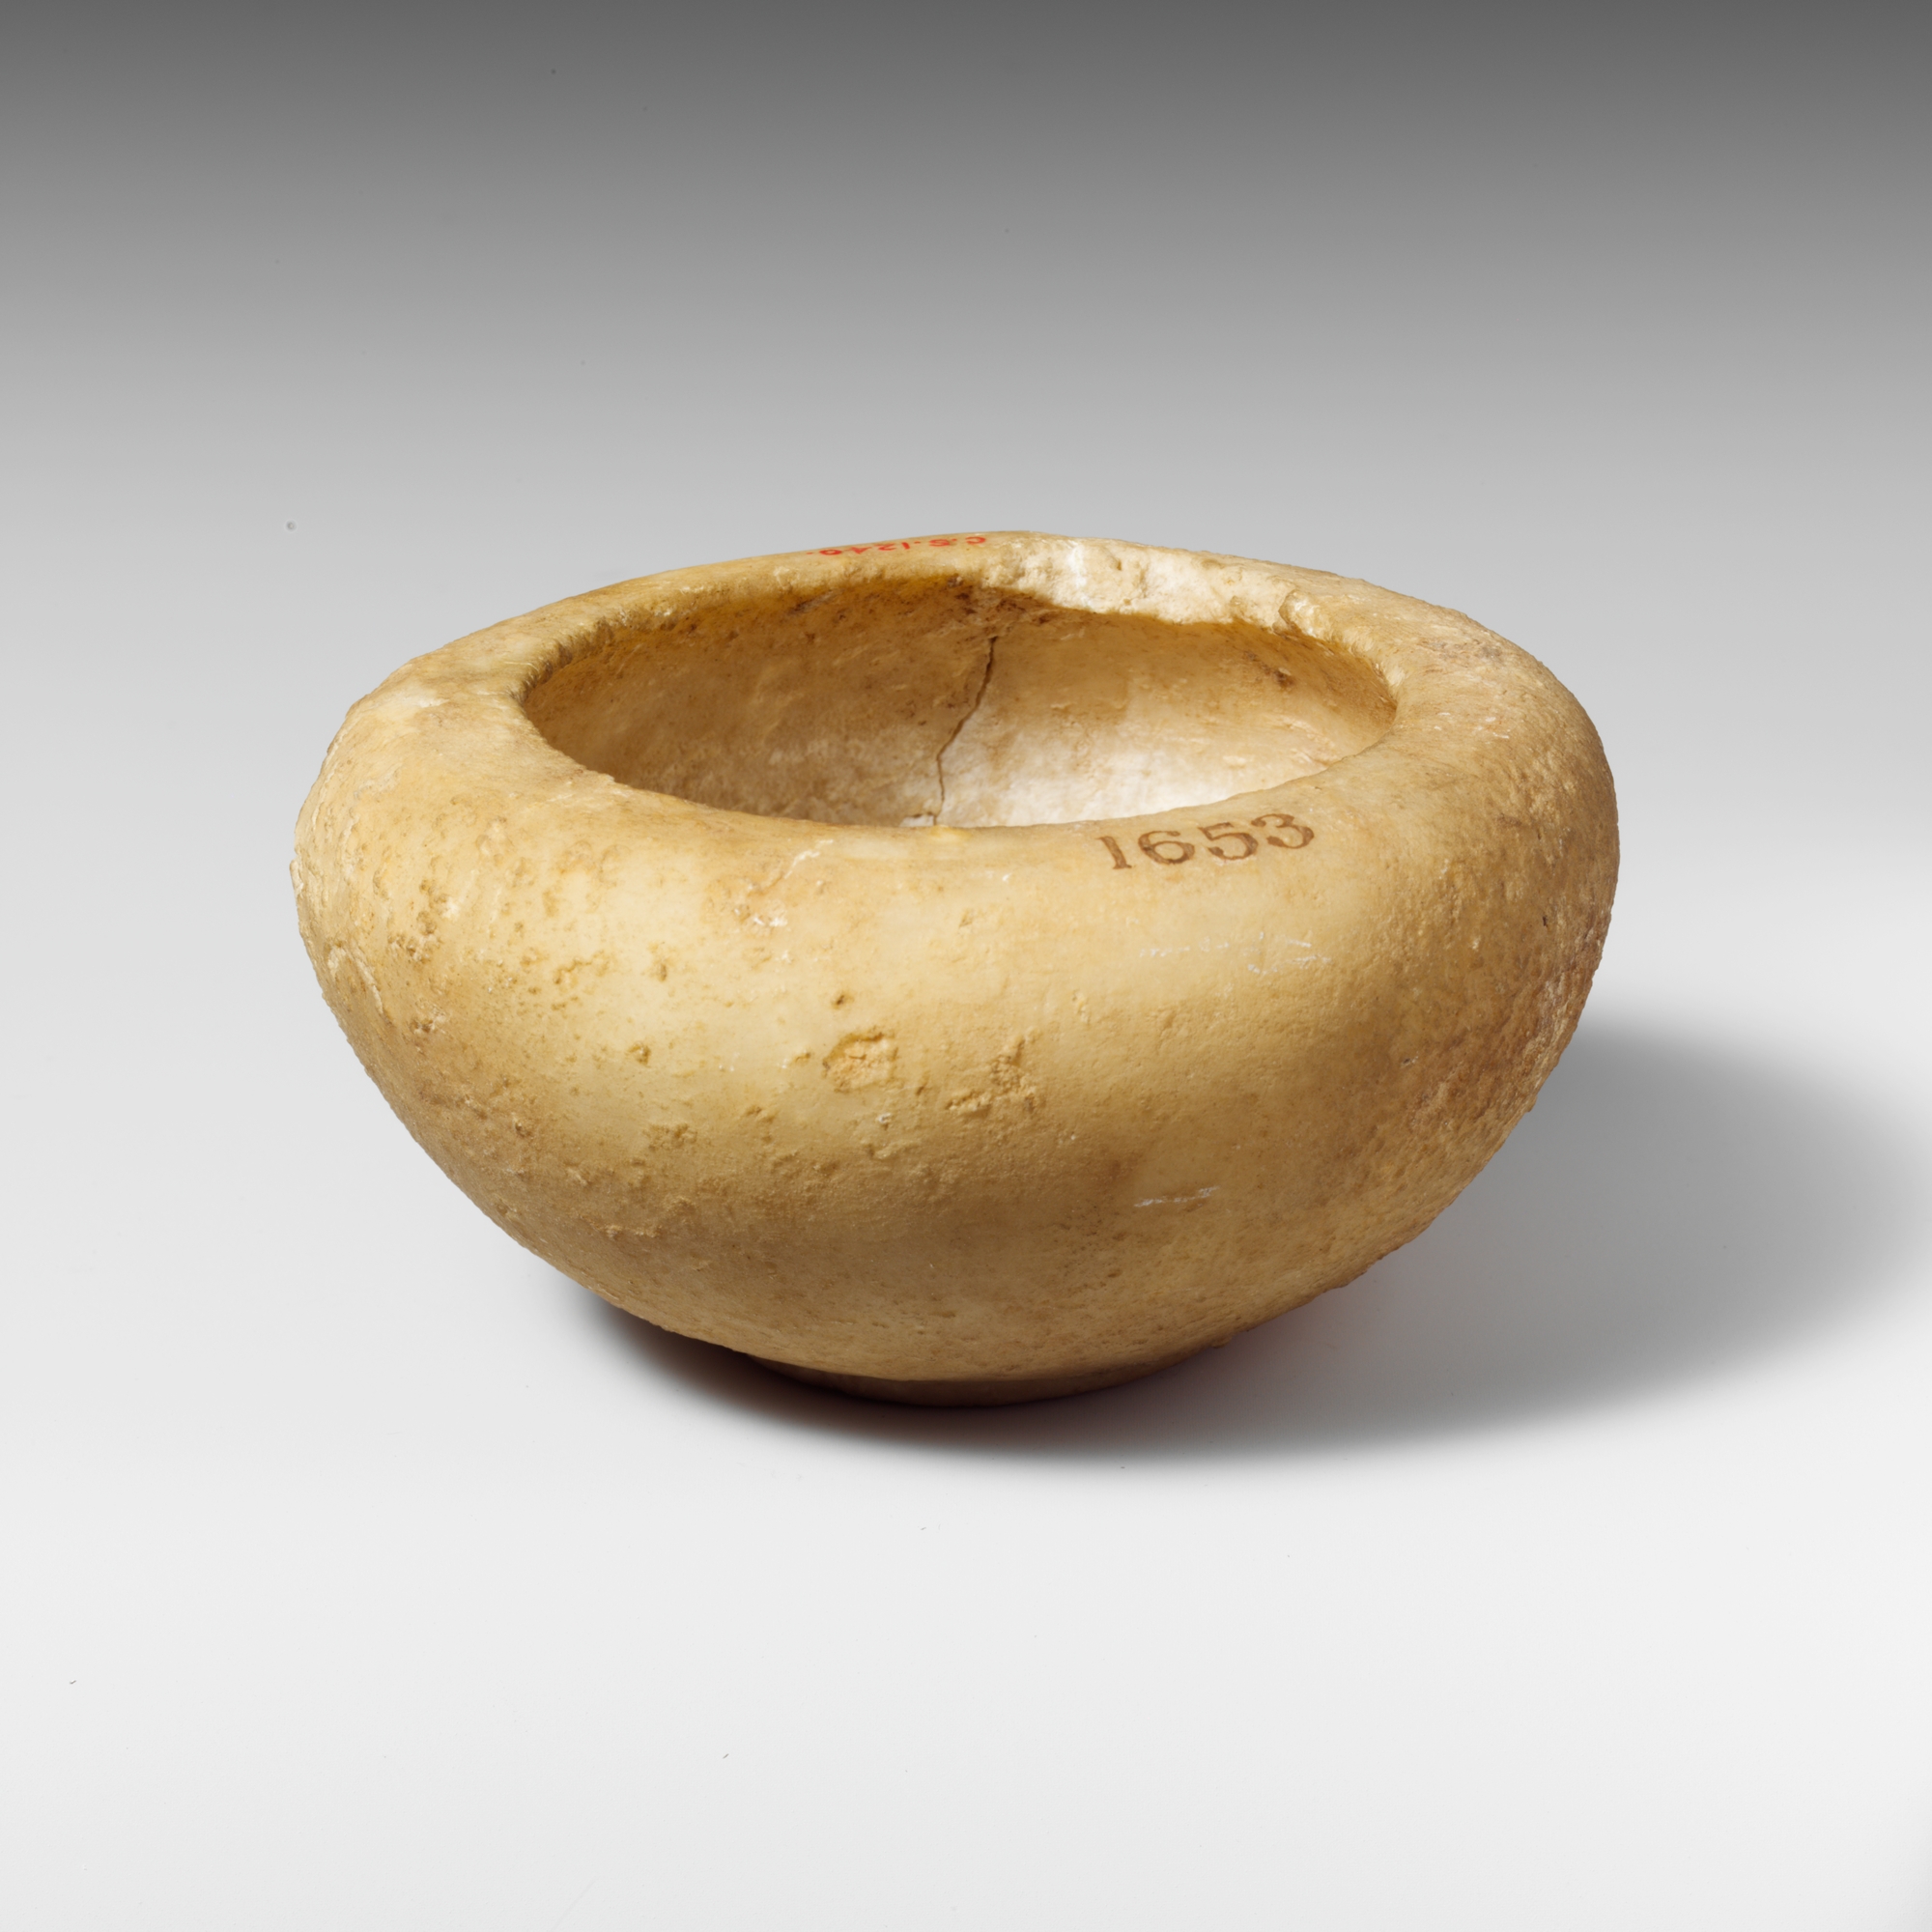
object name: bowl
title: Alabaster bowl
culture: cypriot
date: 600-301 BCE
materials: gypsum